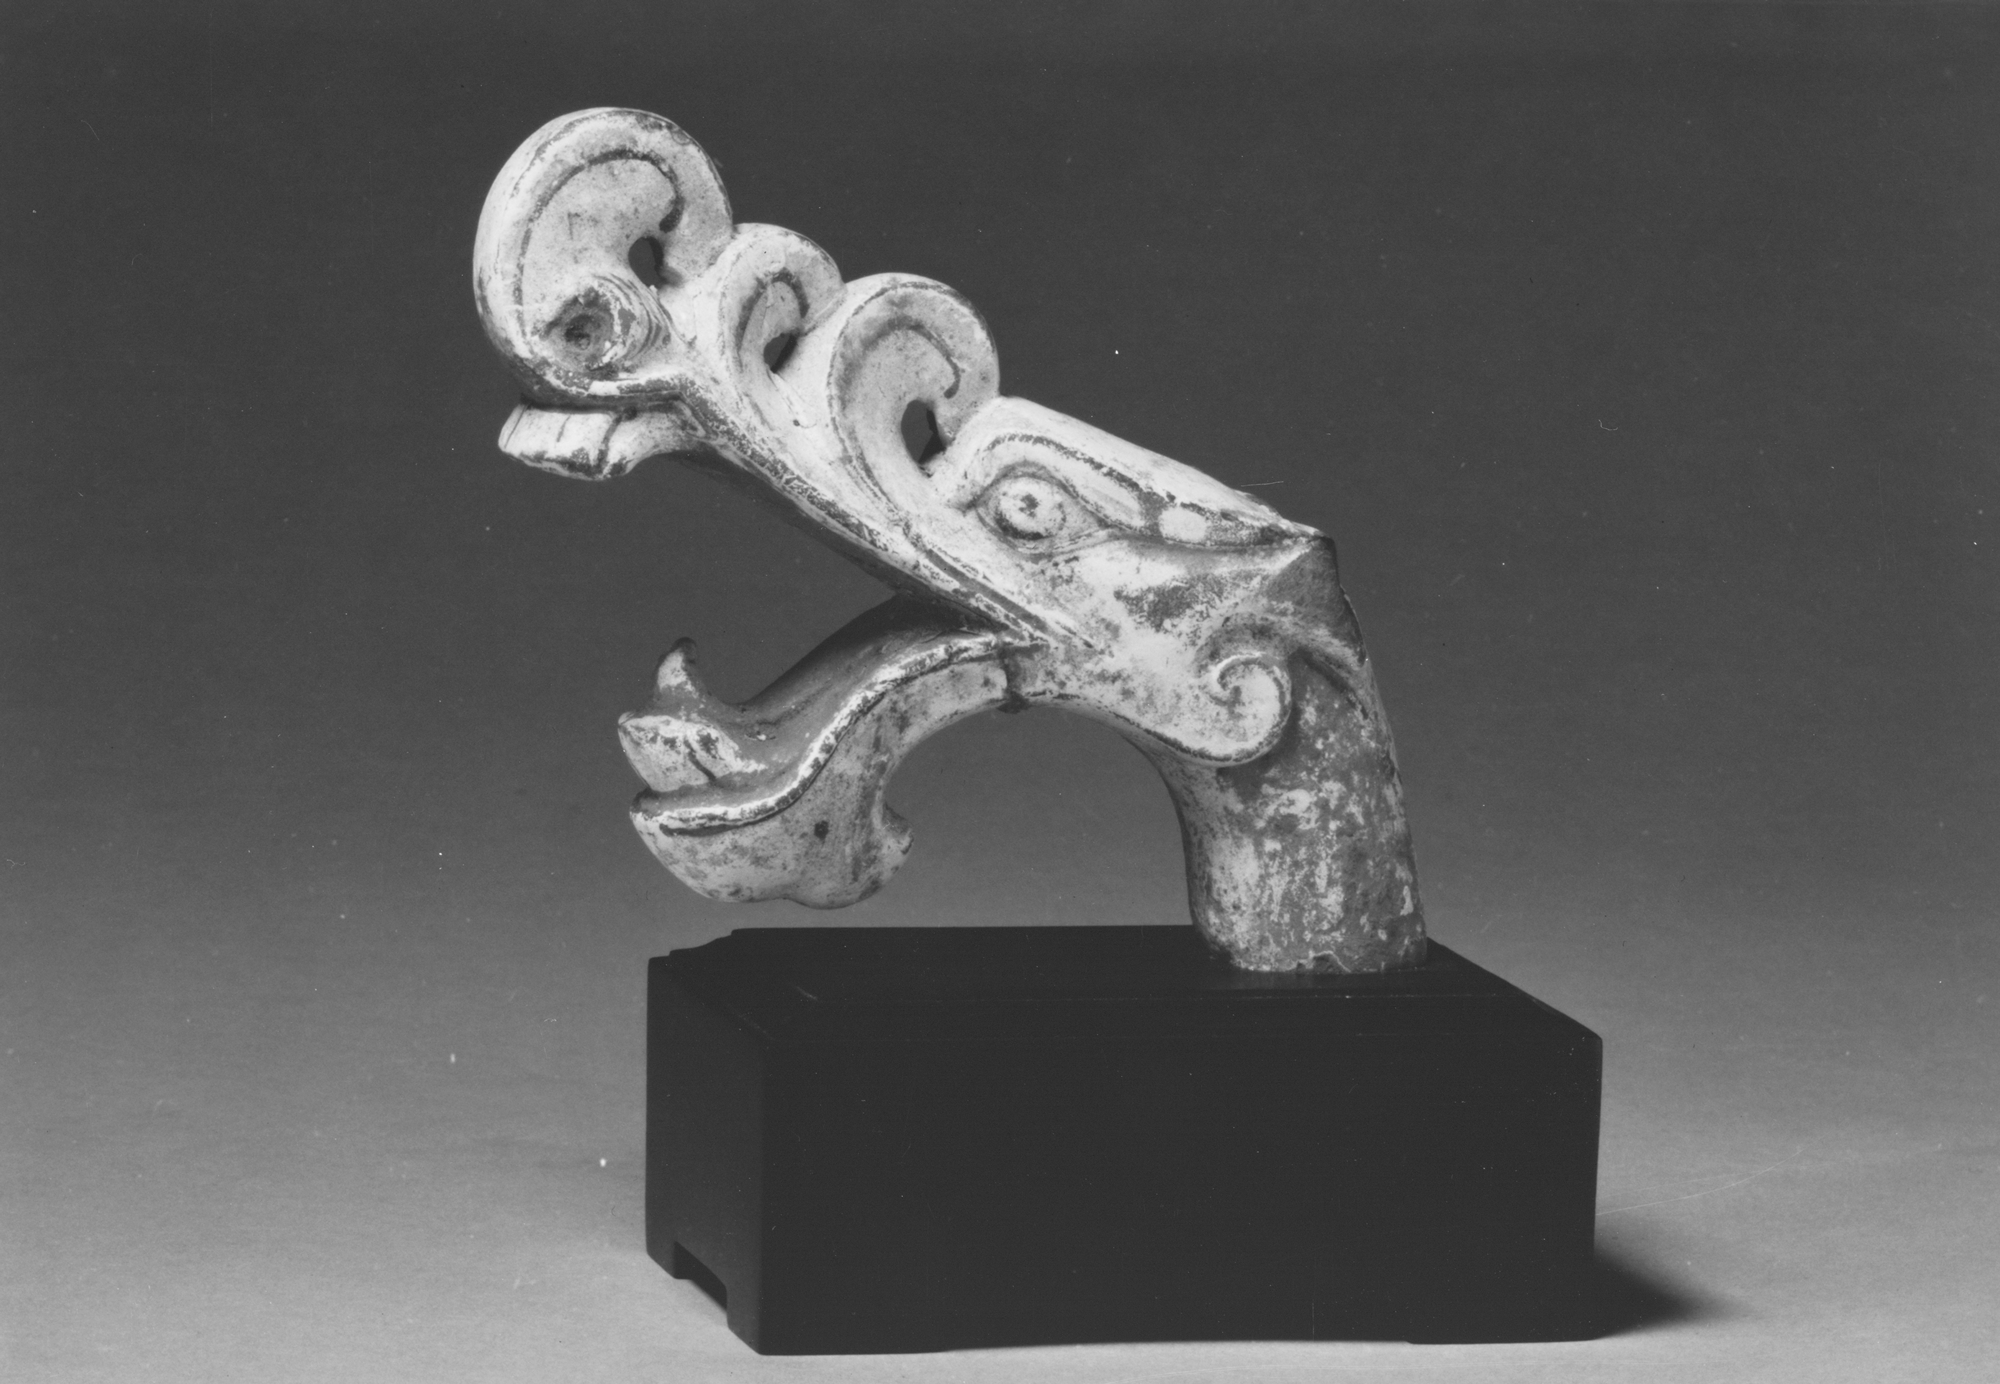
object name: tomb figure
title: Tomb Figure of Dragon Head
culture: chinese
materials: earthenware, pigment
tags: heads,dragons